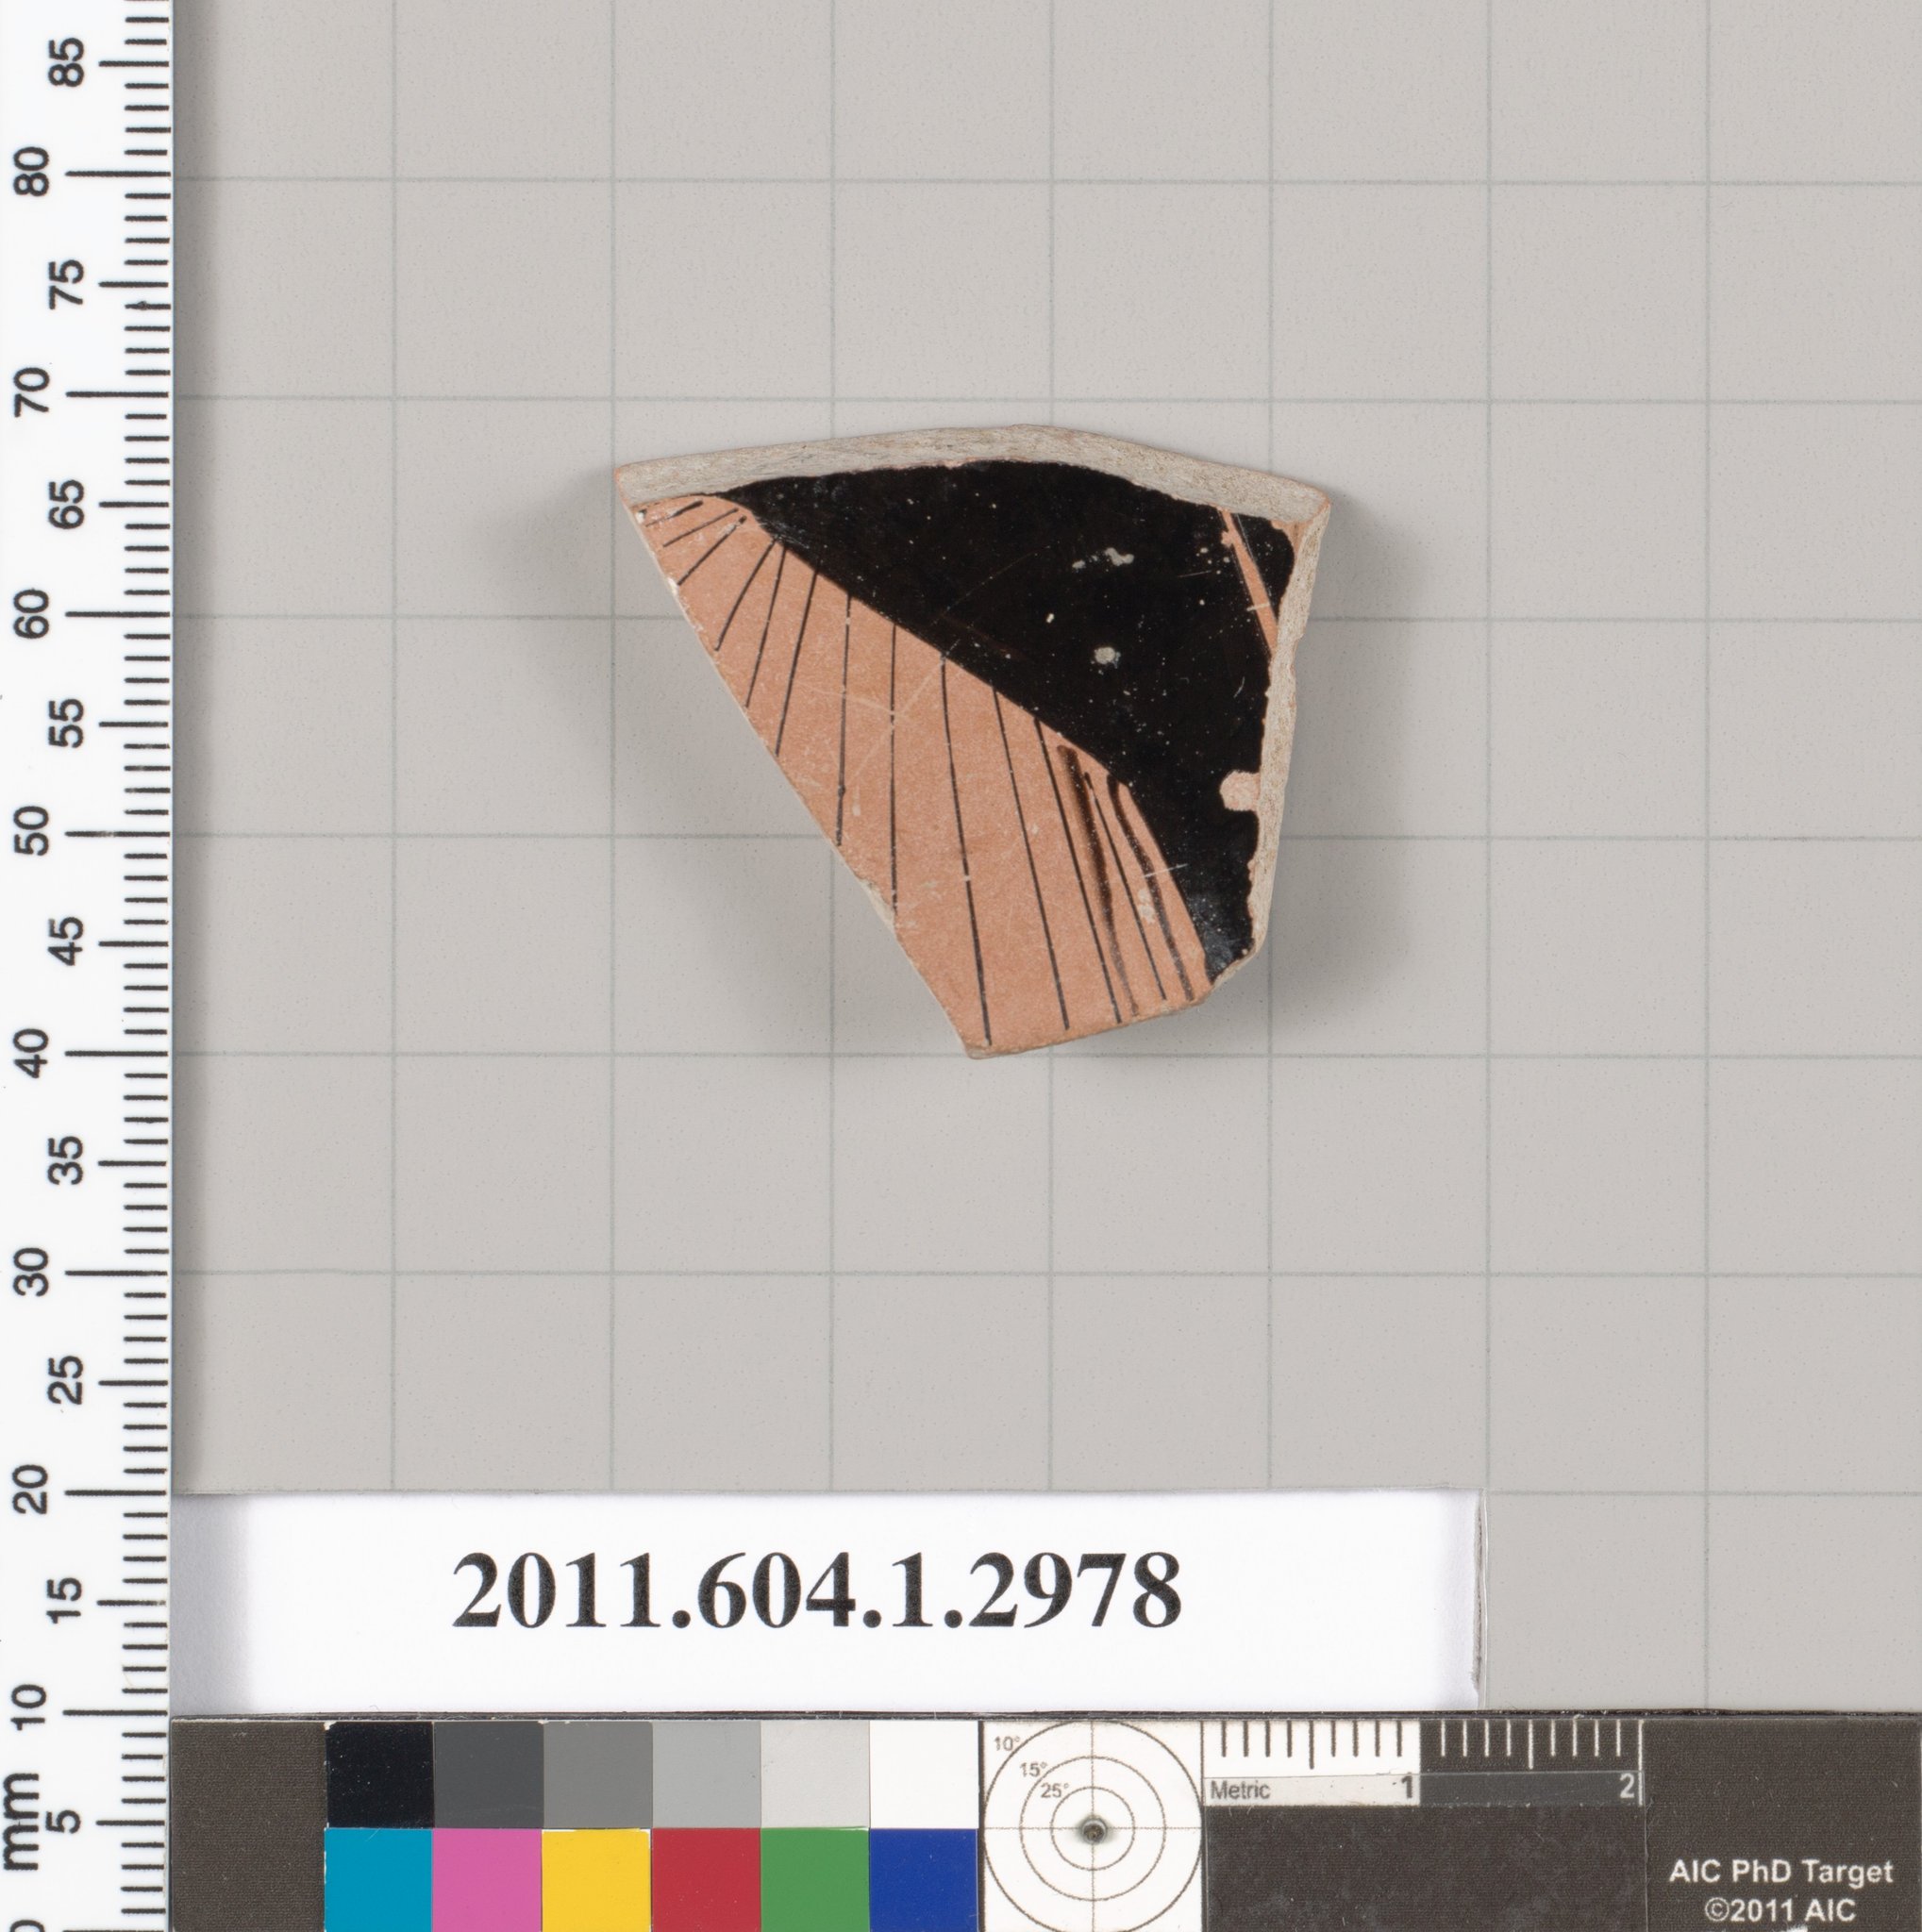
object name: kylix fragment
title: Terracotta fragment of a kylix (drinking cup)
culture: greek, attic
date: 475-451 BCE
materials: terracotta